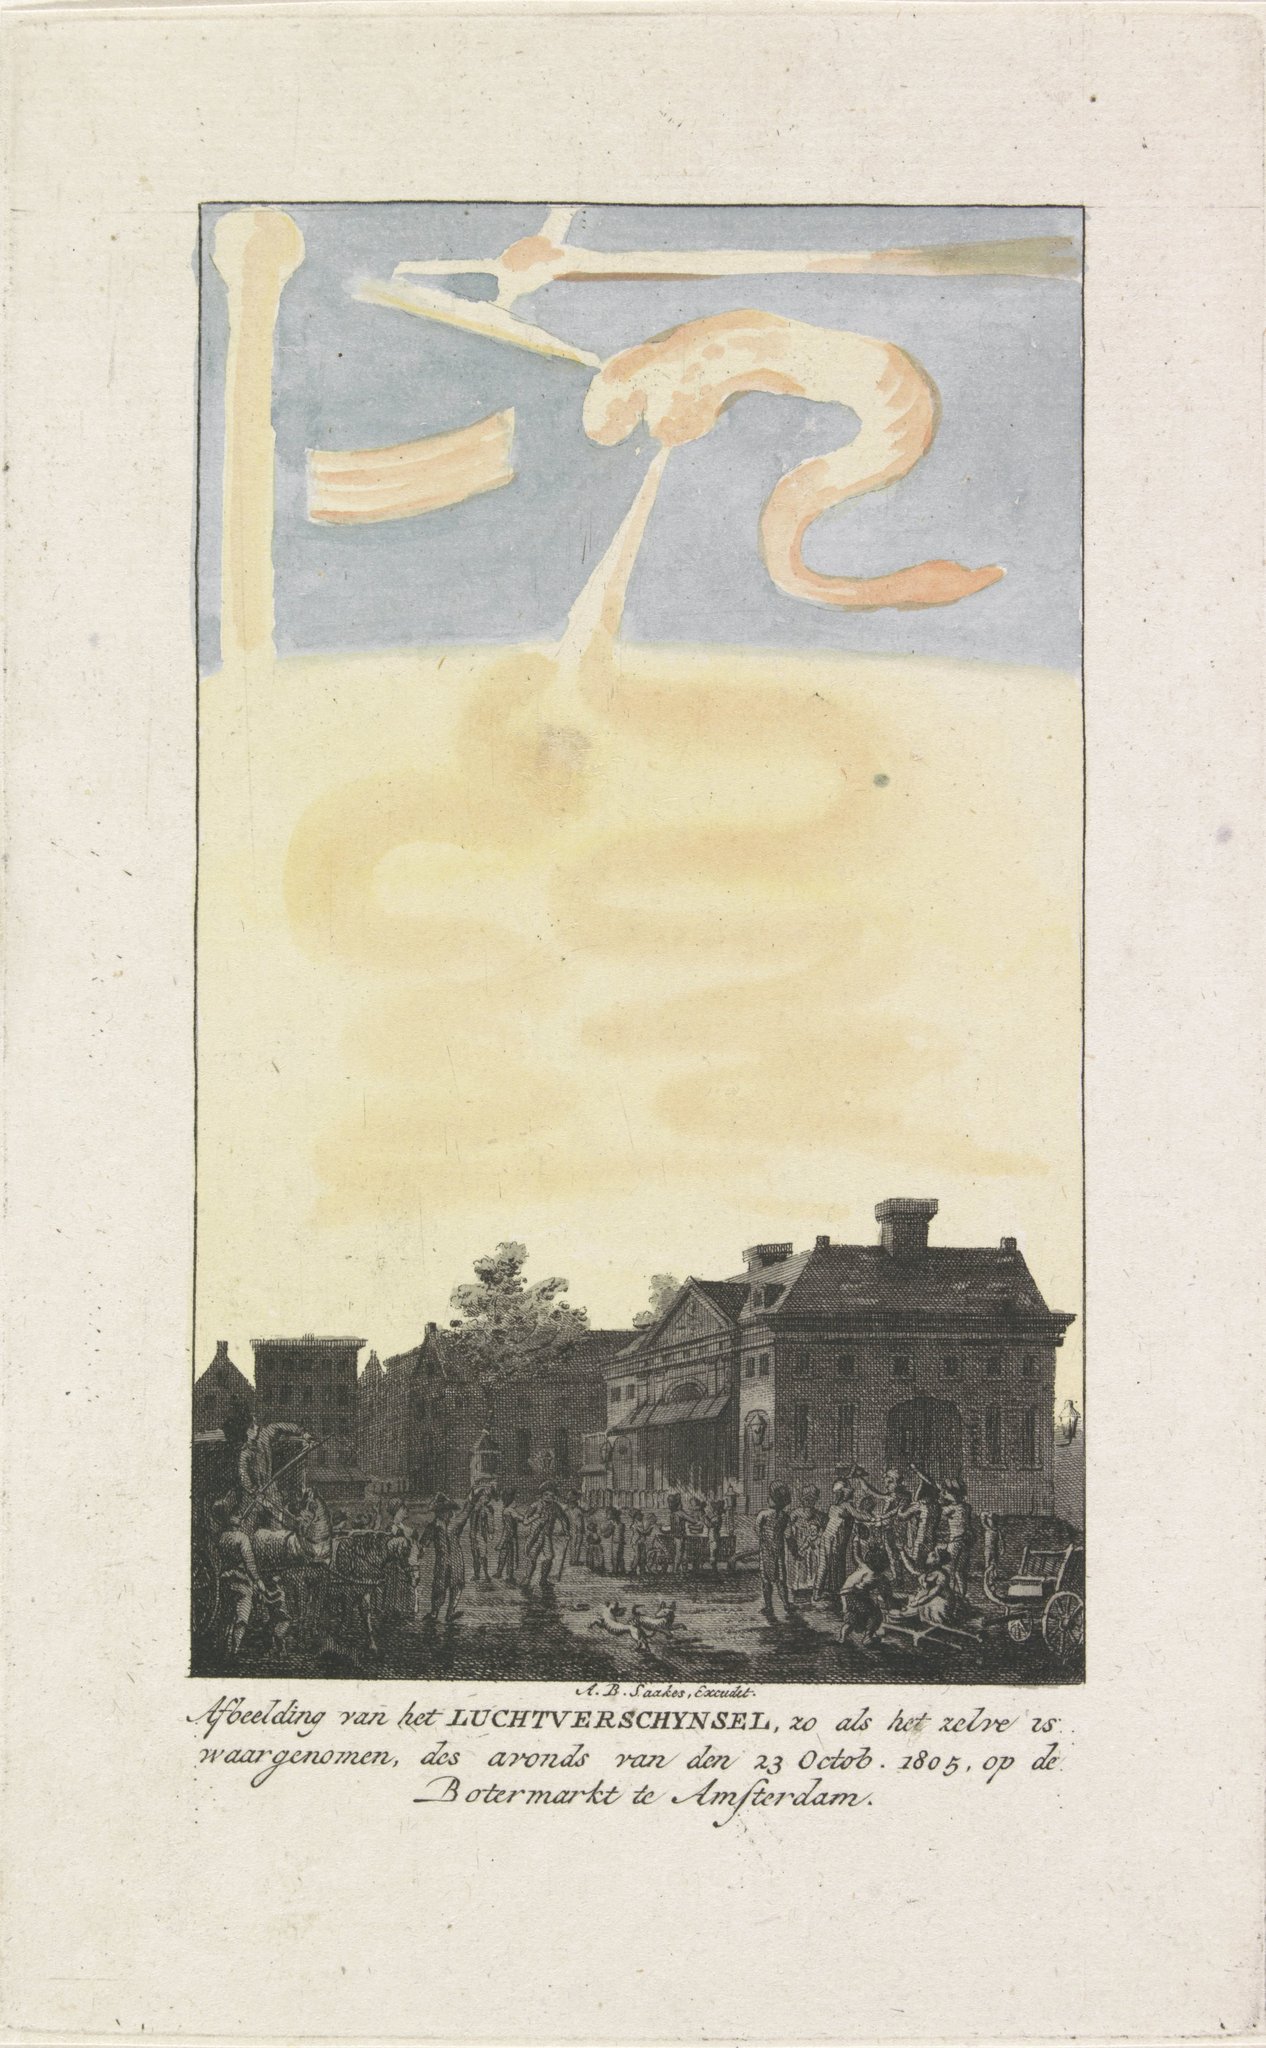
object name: print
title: Luchtverschijnsel waargenomen boven Amsterdam op 23 oktober 1805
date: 1805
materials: paper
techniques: etching, hand coloring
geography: netherlands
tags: firmament, sky, astronomical phenomena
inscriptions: collector's mark: Lugt 2228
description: Luchtverschijnselen waargenomen op de Botermarkt te Amsterdam, 23 oktober 1805.